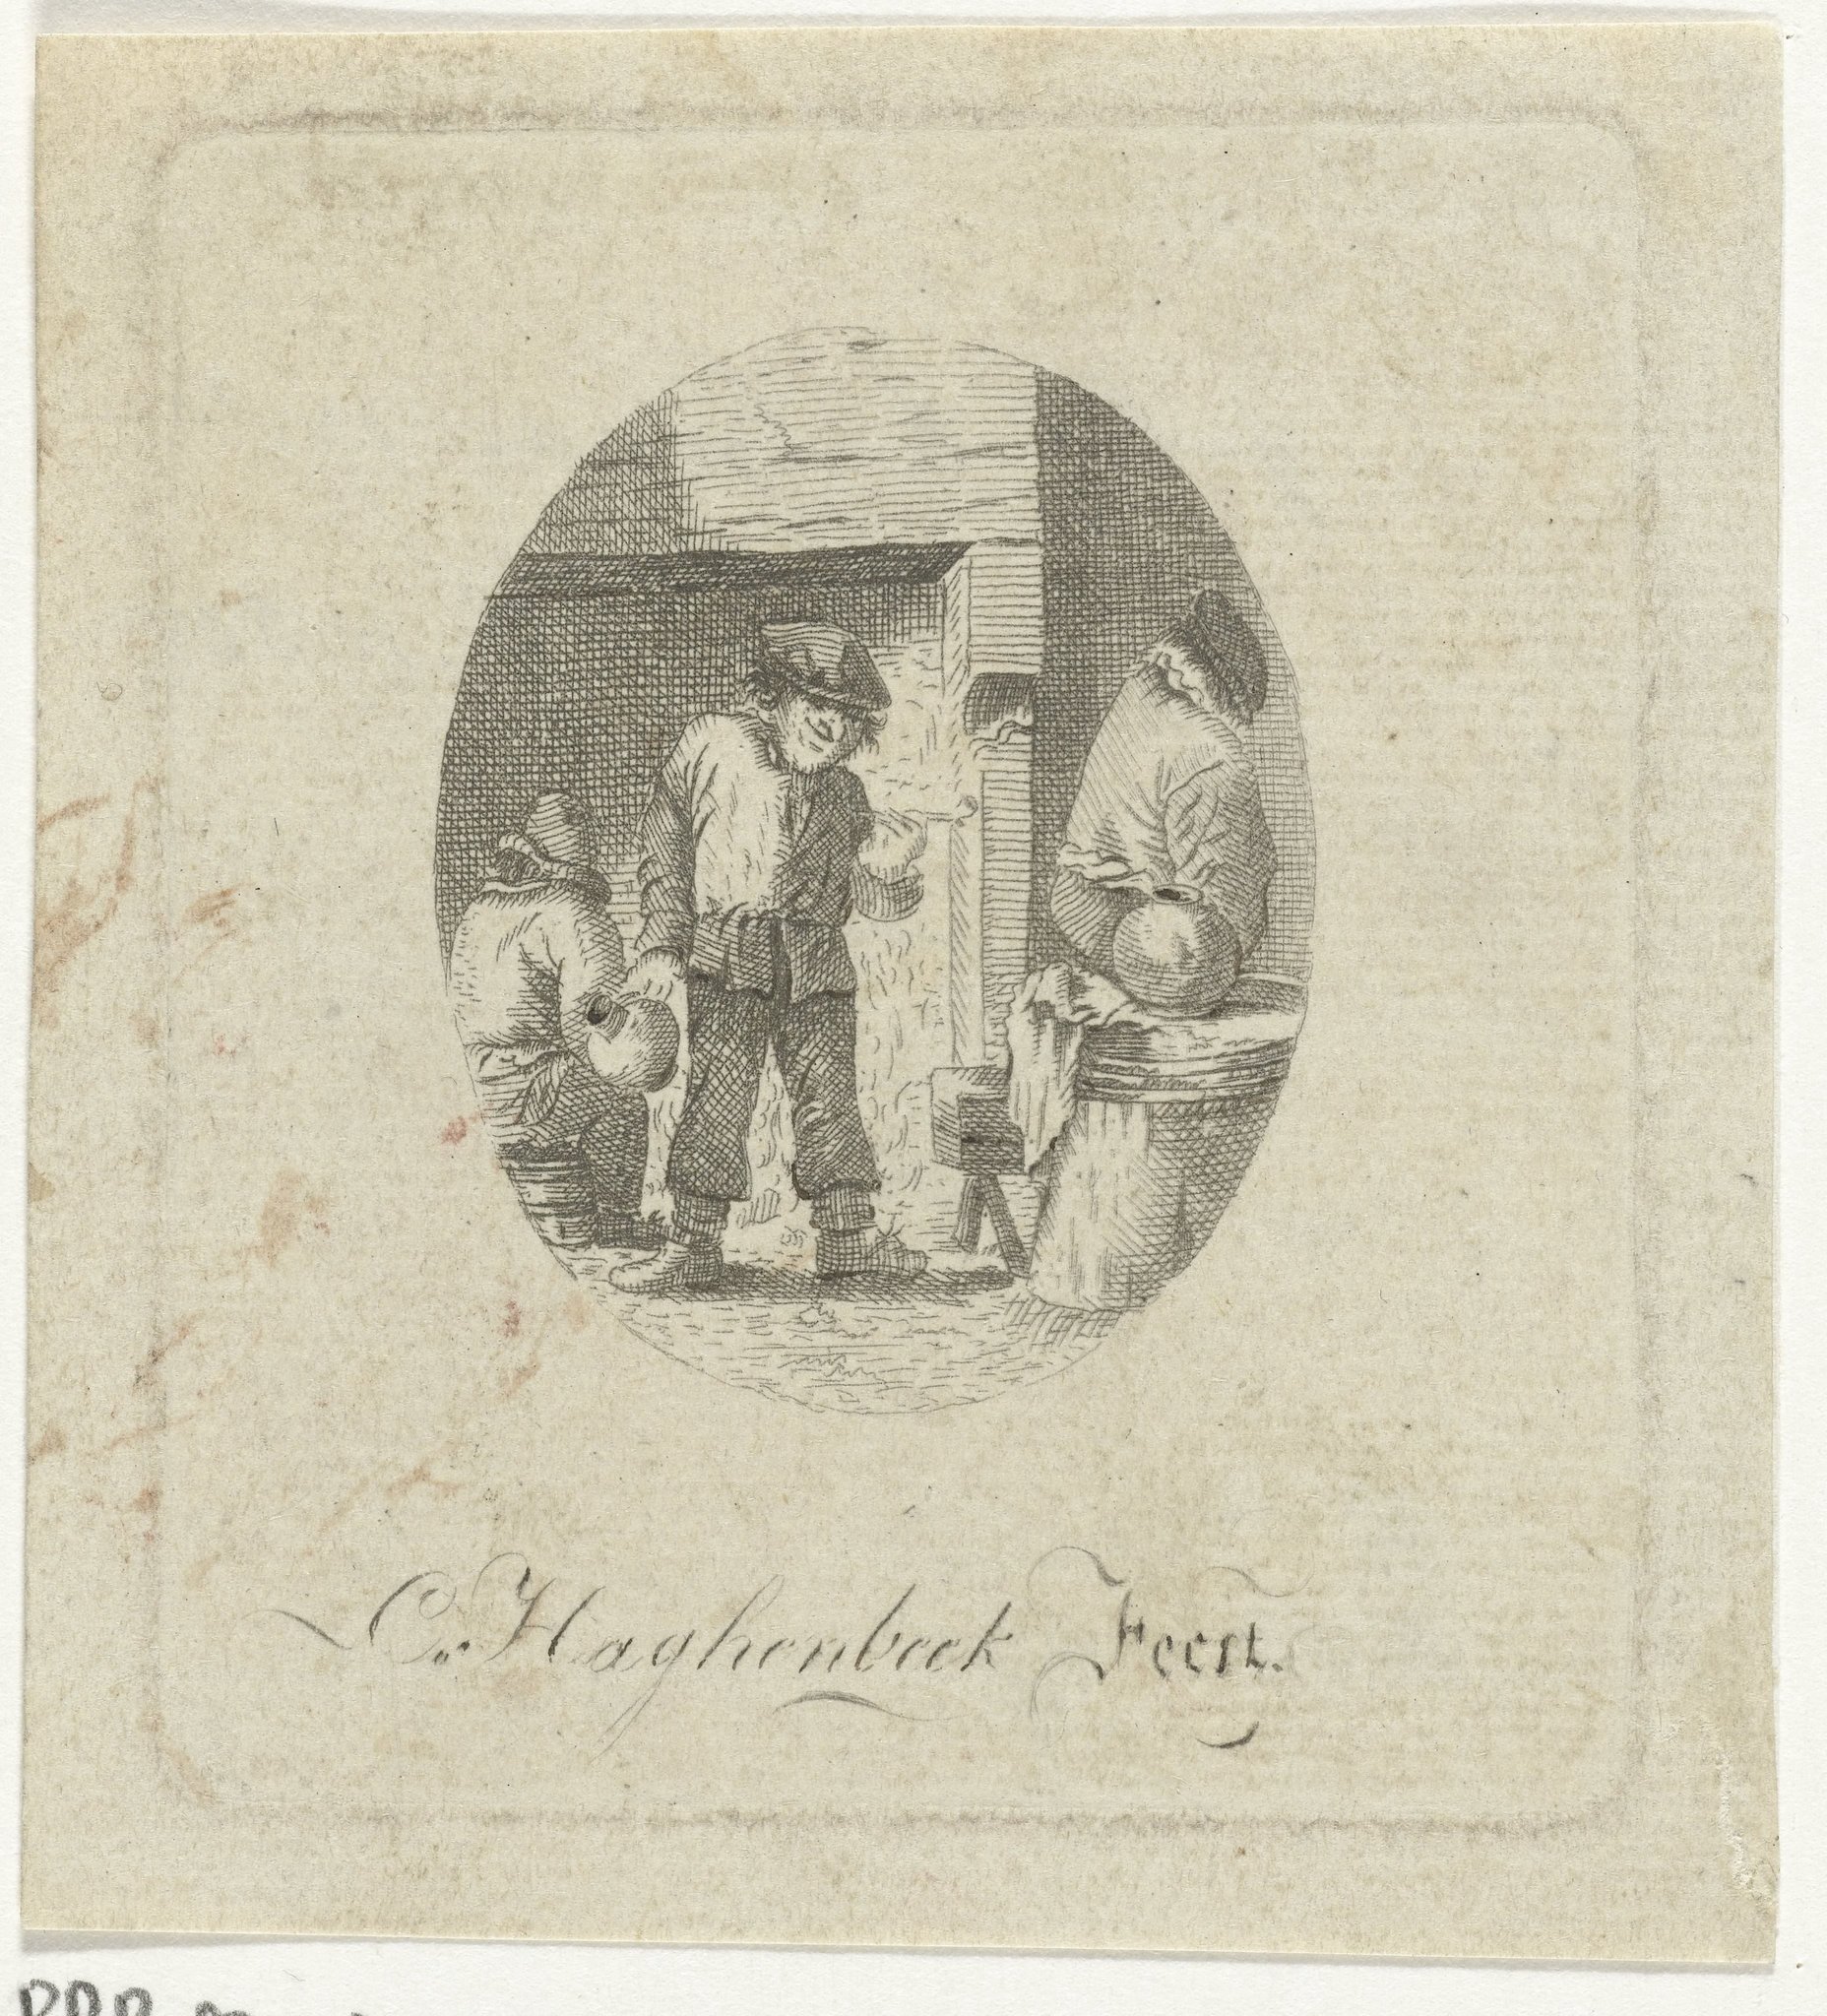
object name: print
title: Drie boeren in een interieur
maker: karel hagenbeek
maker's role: print maker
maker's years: 1780-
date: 1783-1790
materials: paper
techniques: etching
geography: southern netherlands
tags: wooden container: barrel, cask, bucket, open fire (in general), pipe ~ tobacco, jar, jug (used as drinking-vessel), urination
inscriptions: collector's mark: Lugt 2228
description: Drie boeren in een interieur bij een ton en een open haard. Links een zittende man, in het midden een met een pijp, rechts een plassend tegen een muur.